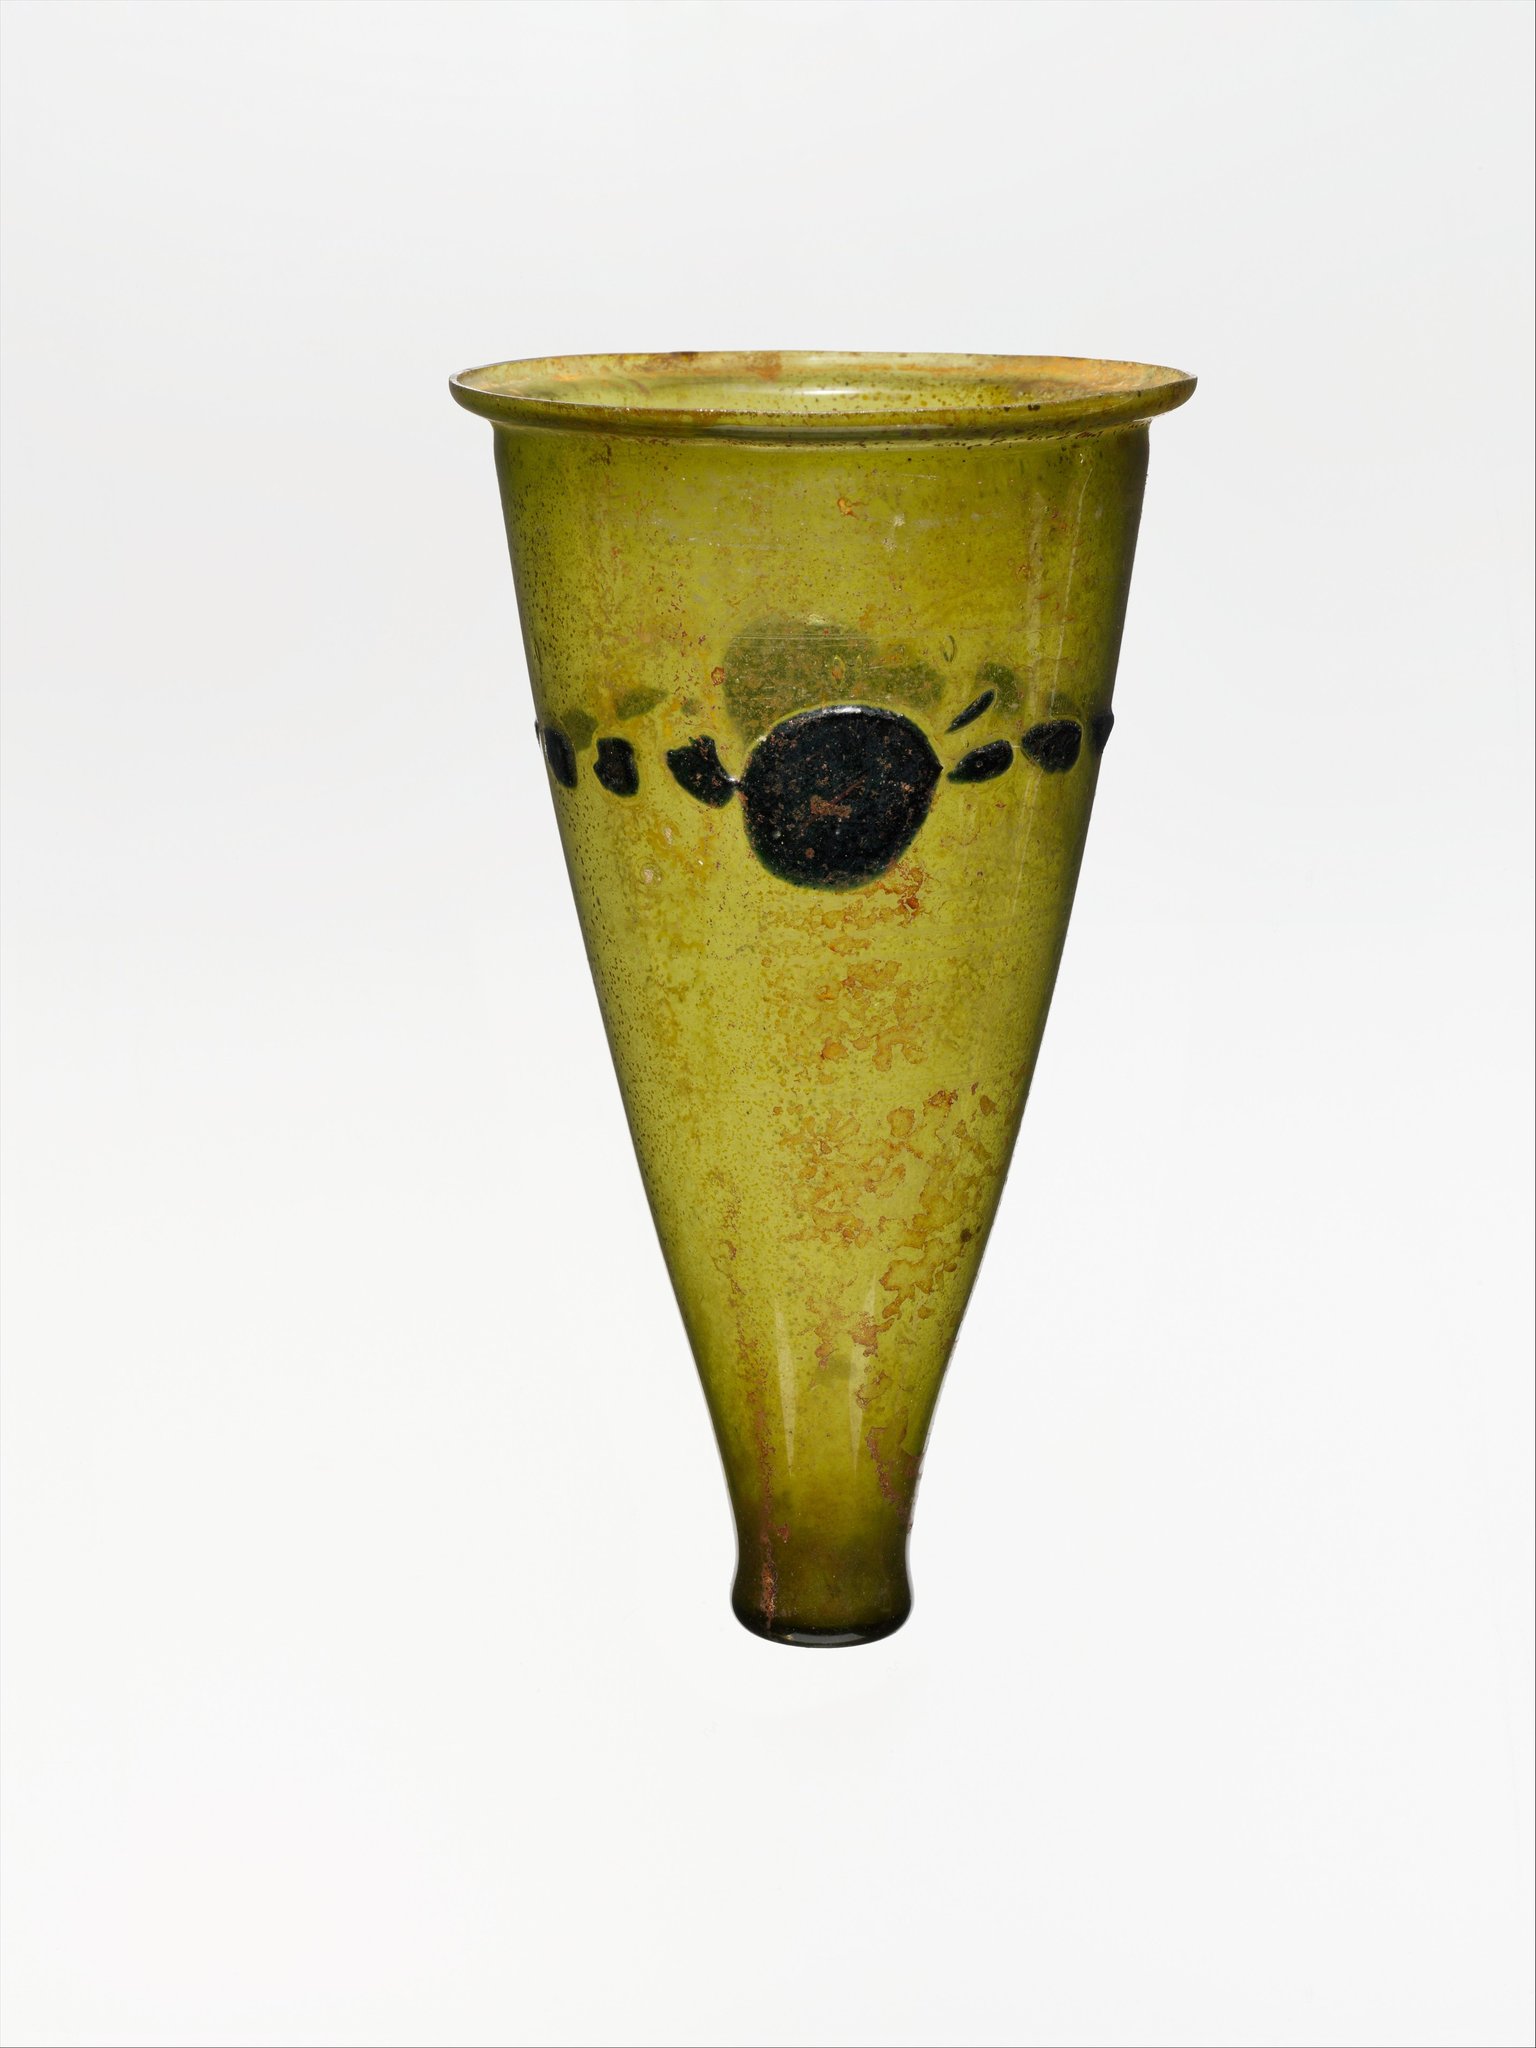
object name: beaker or lamp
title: Glass beaker or lamp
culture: roman, eastern mediterranean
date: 301-400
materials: glass